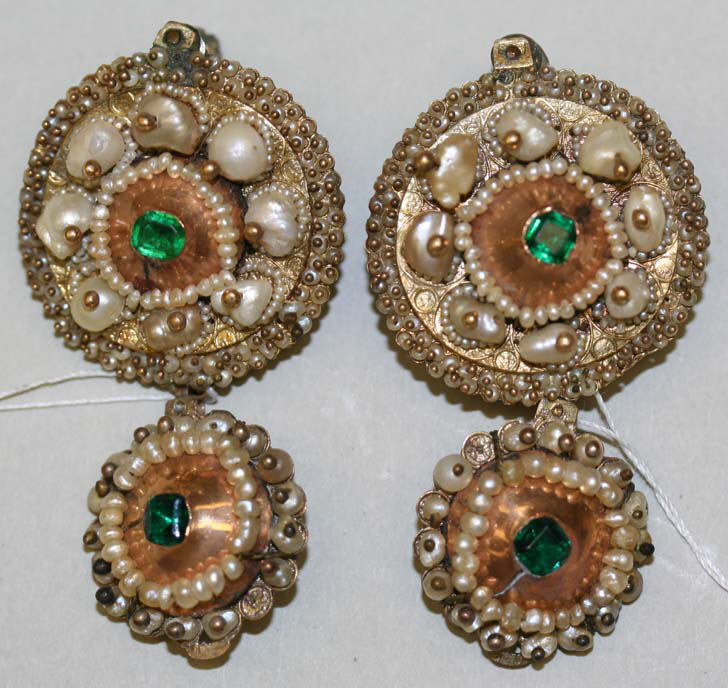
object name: earring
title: Earrings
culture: indian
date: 1801-1833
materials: pearl, silver